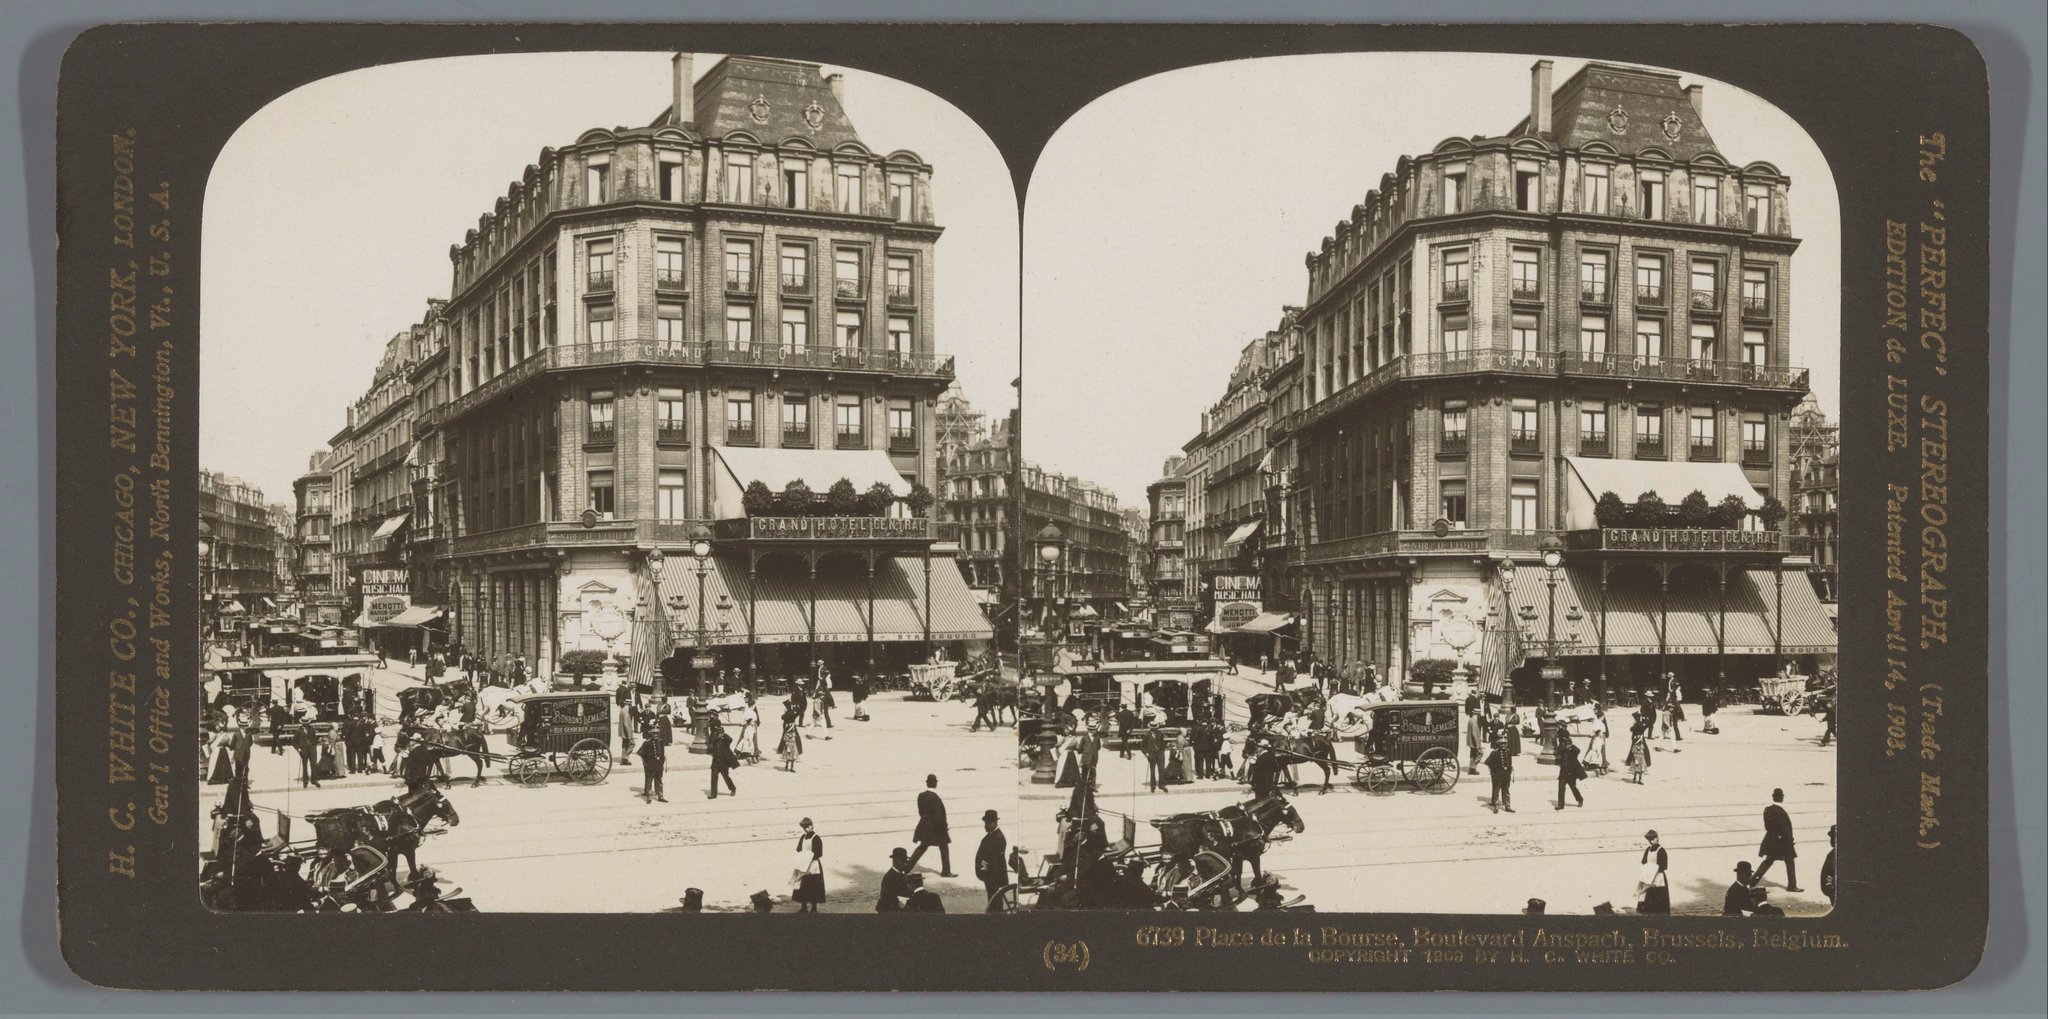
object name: stereograph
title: Gezicht op het Beursplein en de Anspachlaan in Brussel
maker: Anonymous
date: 1909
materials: cardboard, photographic support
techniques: gelatin silver print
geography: new york city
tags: square, place, circus, etc., urban housing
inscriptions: copyright notice: ‘Copyright 1909 by H. C. White Co.’, number: ‘6739’, number: ‘(34)’, inscription: ‘11’, inscription: ‘The " PERFEC" STEREOGRAPH. (Trade Mark.)/ EDITION de LUXE. Patented April 14, 1903.’, inscription: ‘Juli-Augustus 1910’, inscription: ‘All Perfec-Stereograph subjects may be secured in Lantern Slides and Enlargements.’